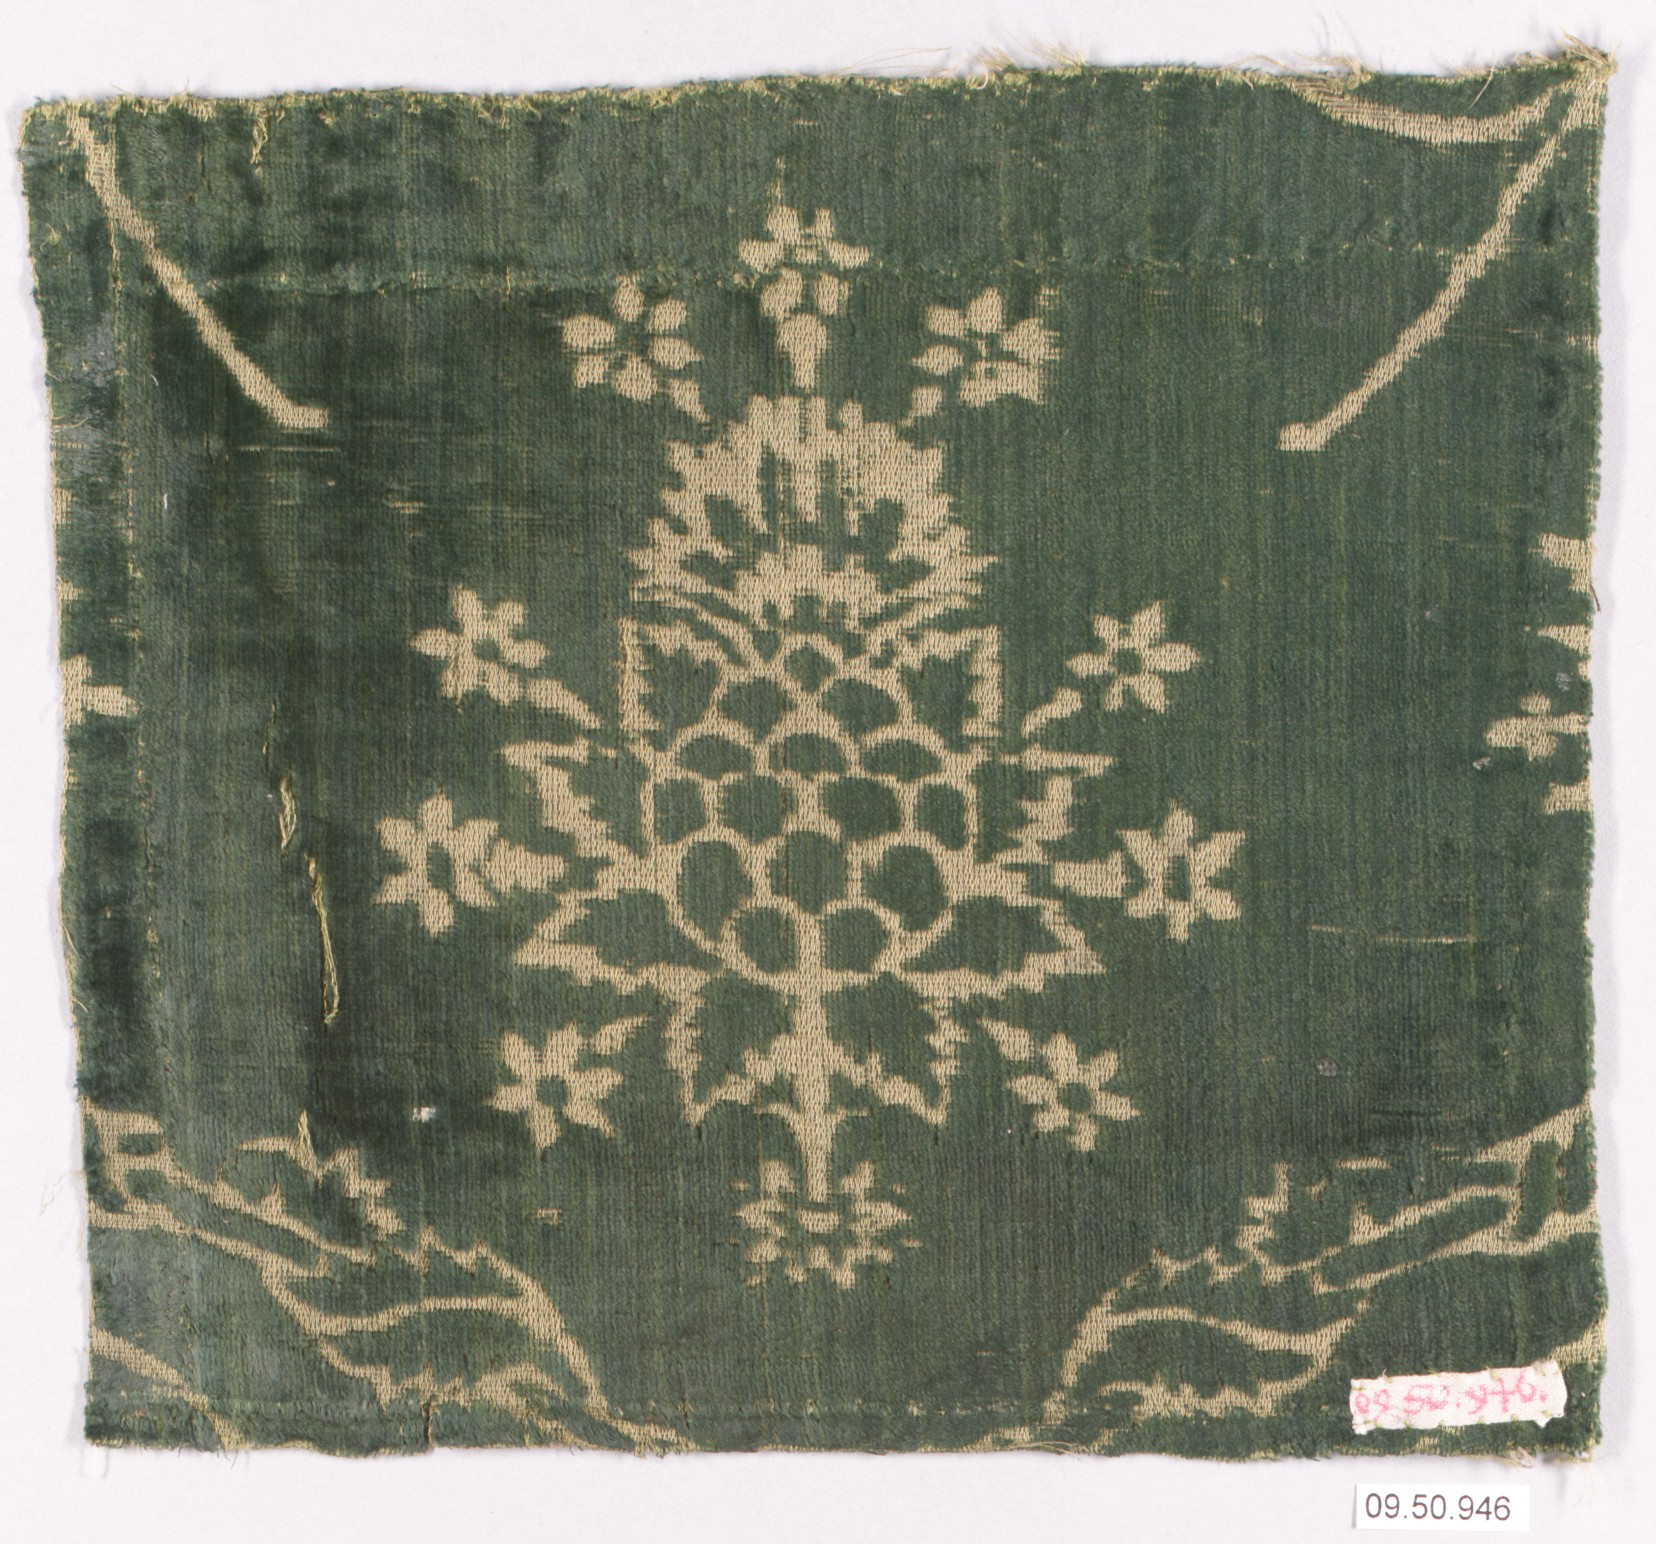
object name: piece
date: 1401-1500